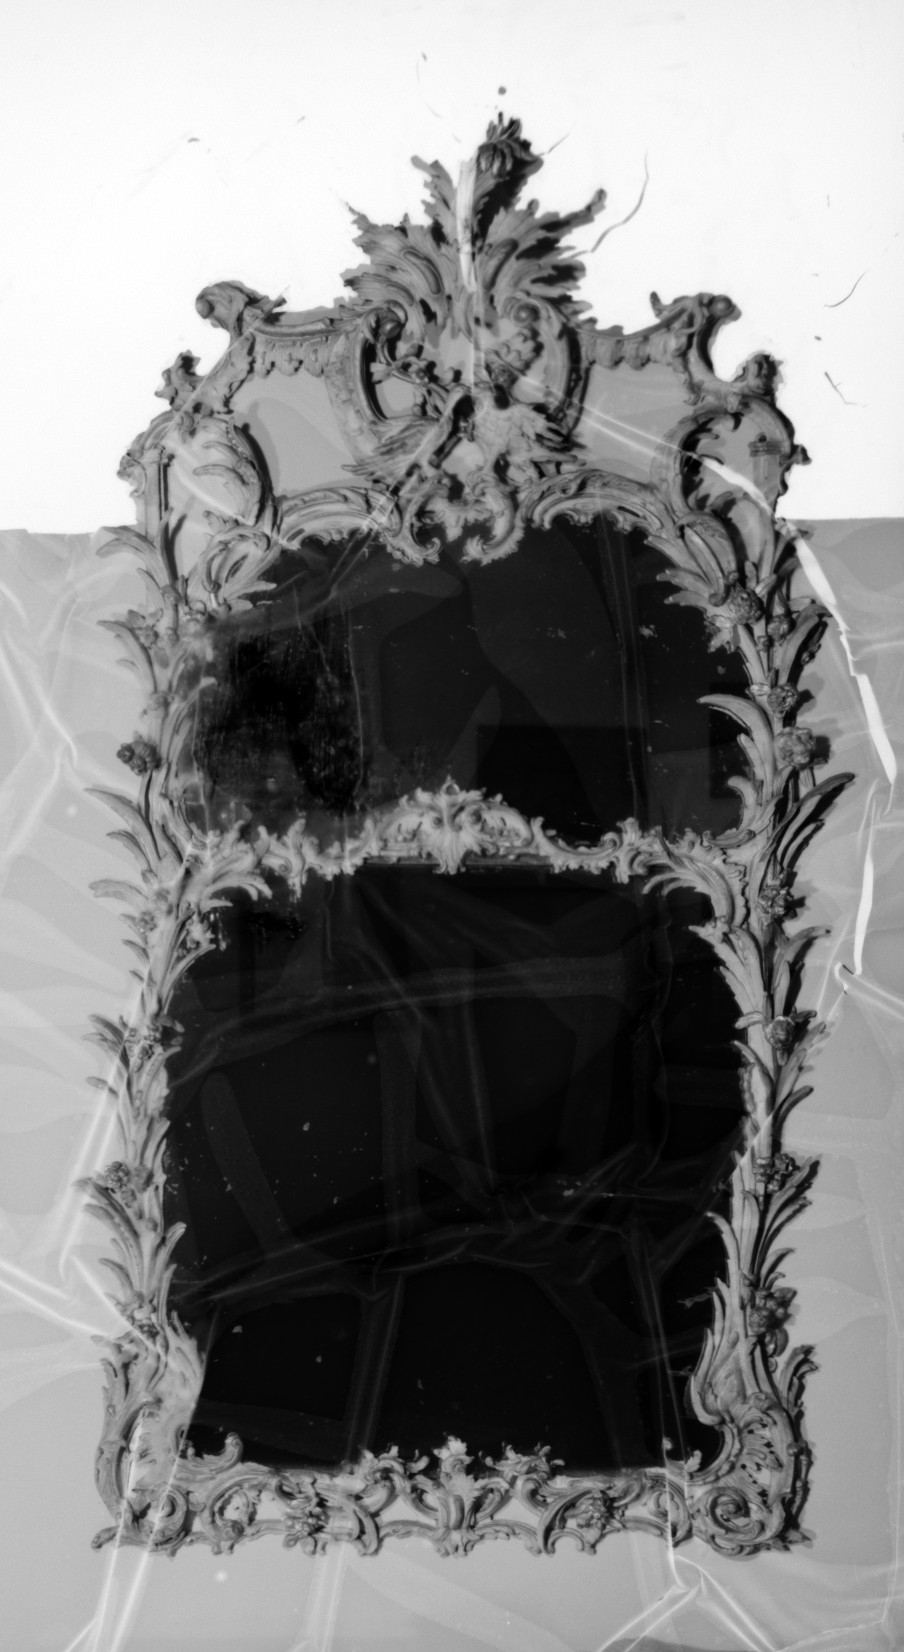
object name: mirror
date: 1750-1755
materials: wood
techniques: gilding, painting